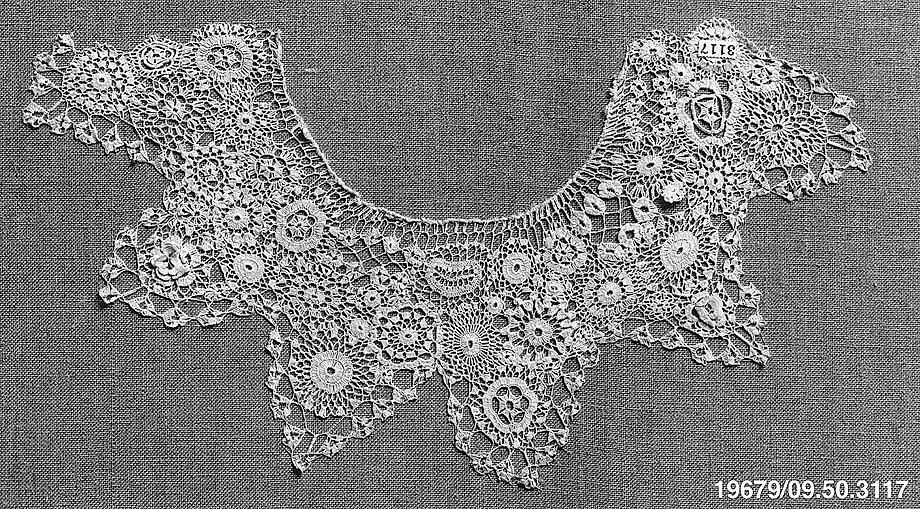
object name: collar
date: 1801-1900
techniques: crochet